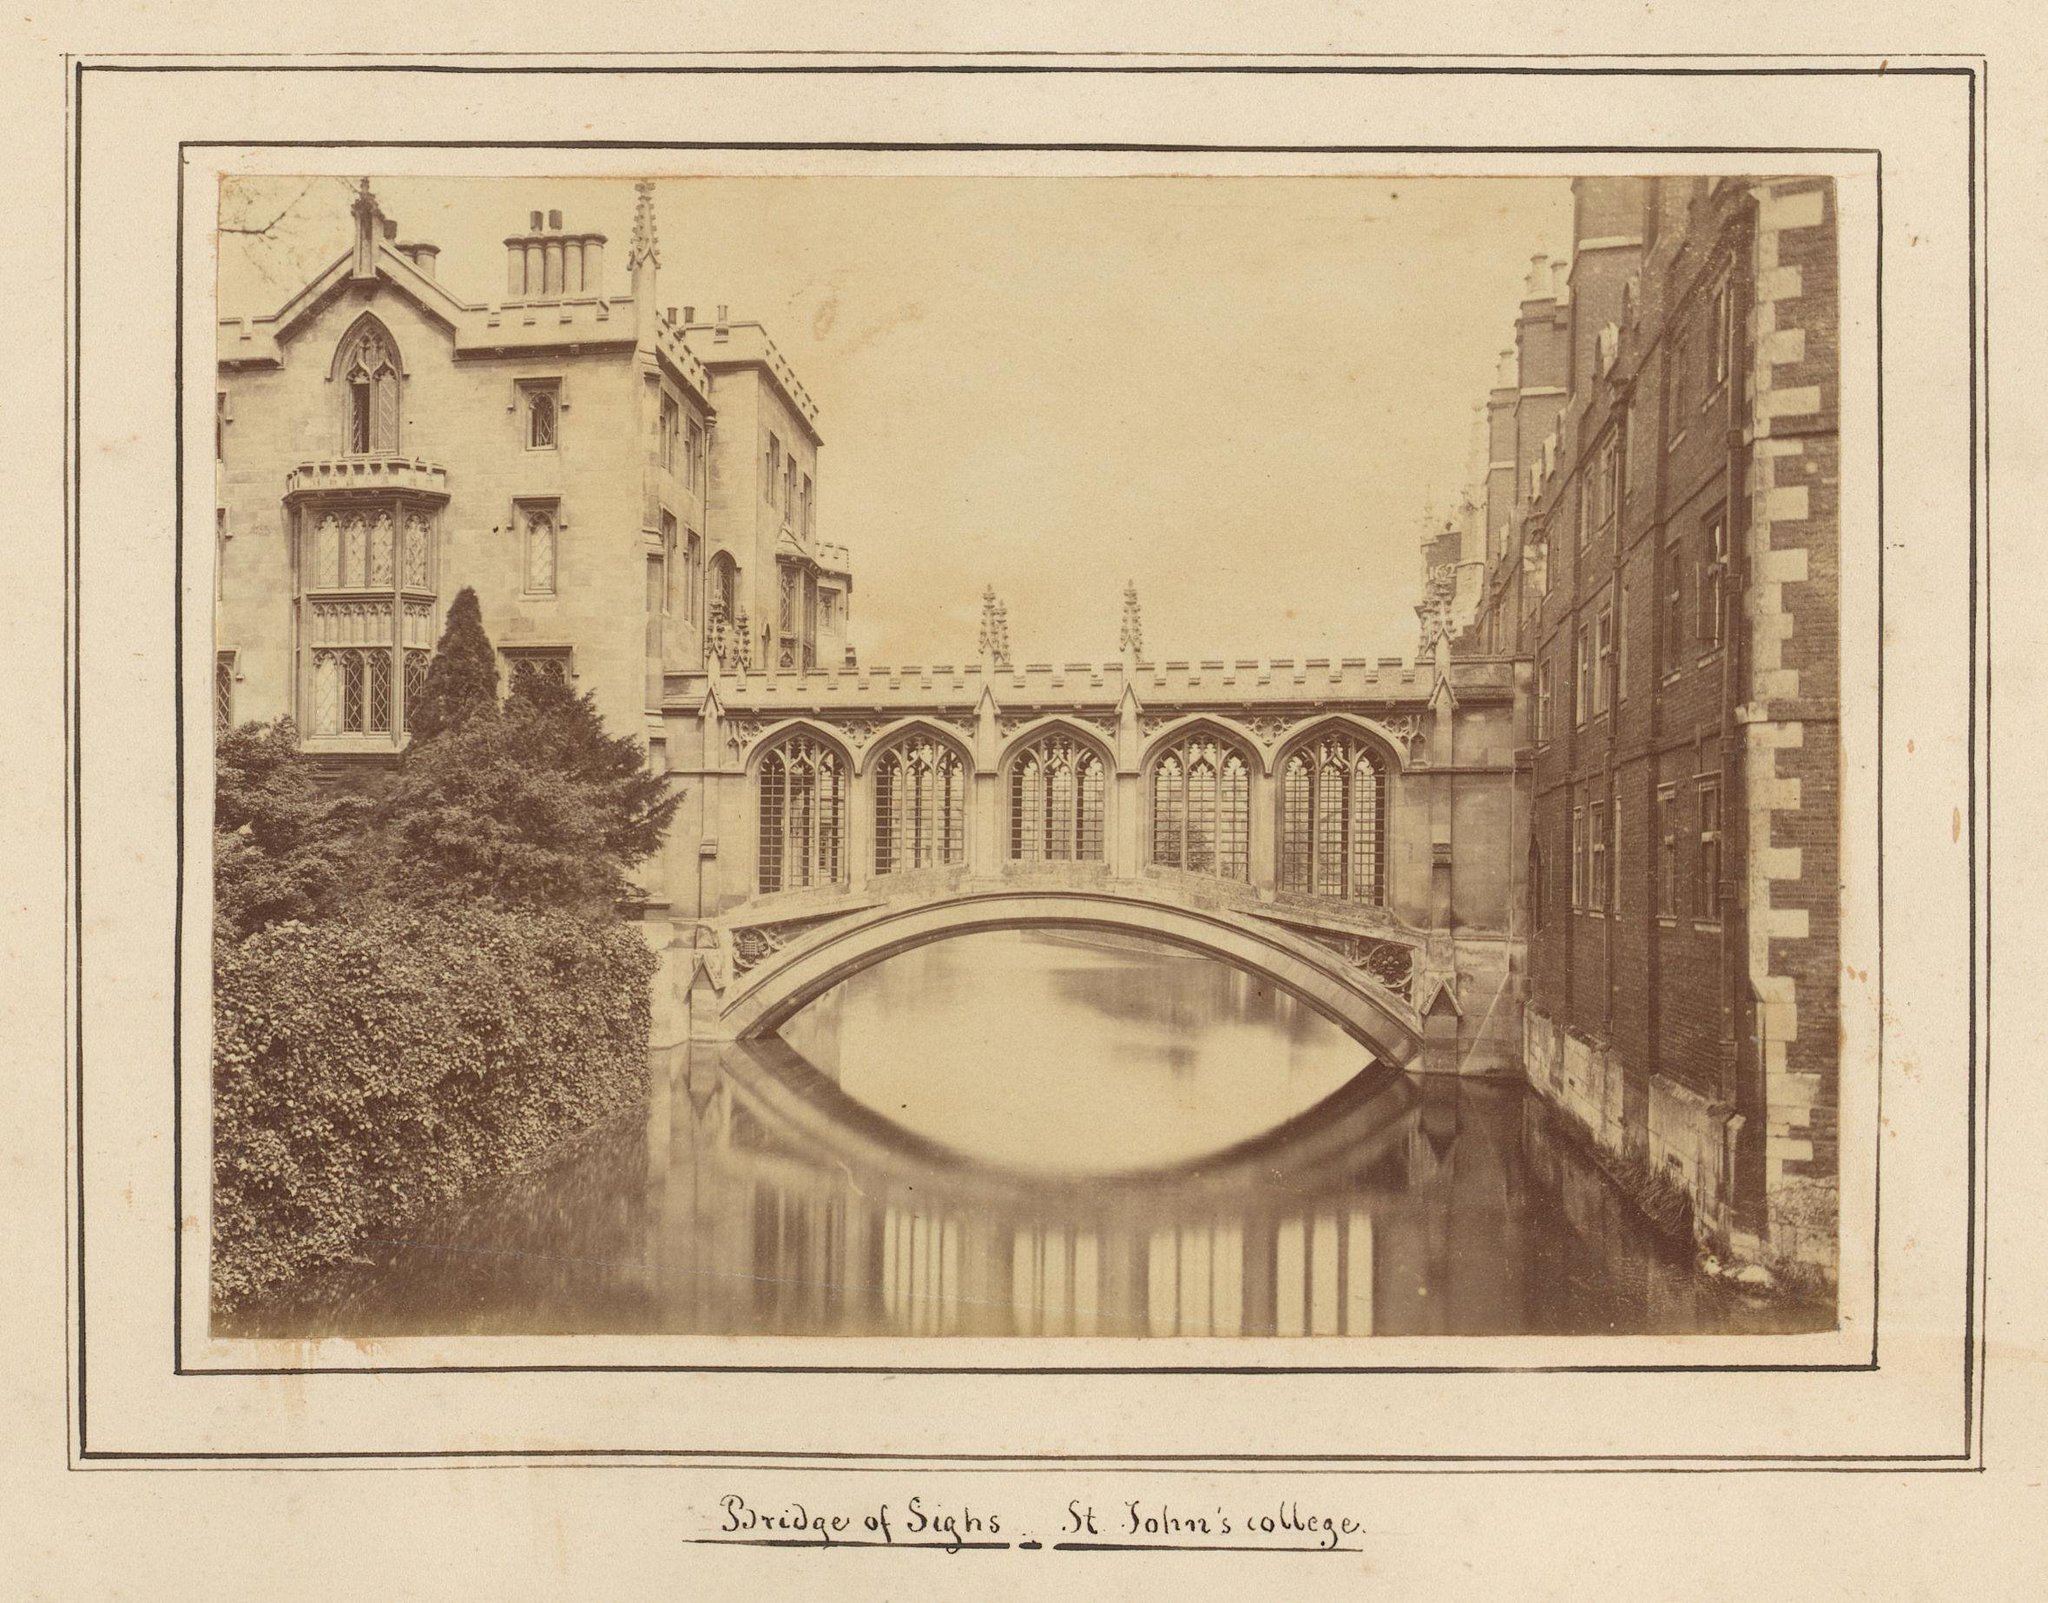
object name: album leaf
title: Bridge of Sighs, St John's college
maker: Anonymous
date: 1865-1890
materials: paper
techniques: albumen print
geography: cambridge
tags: university building, college, bridge